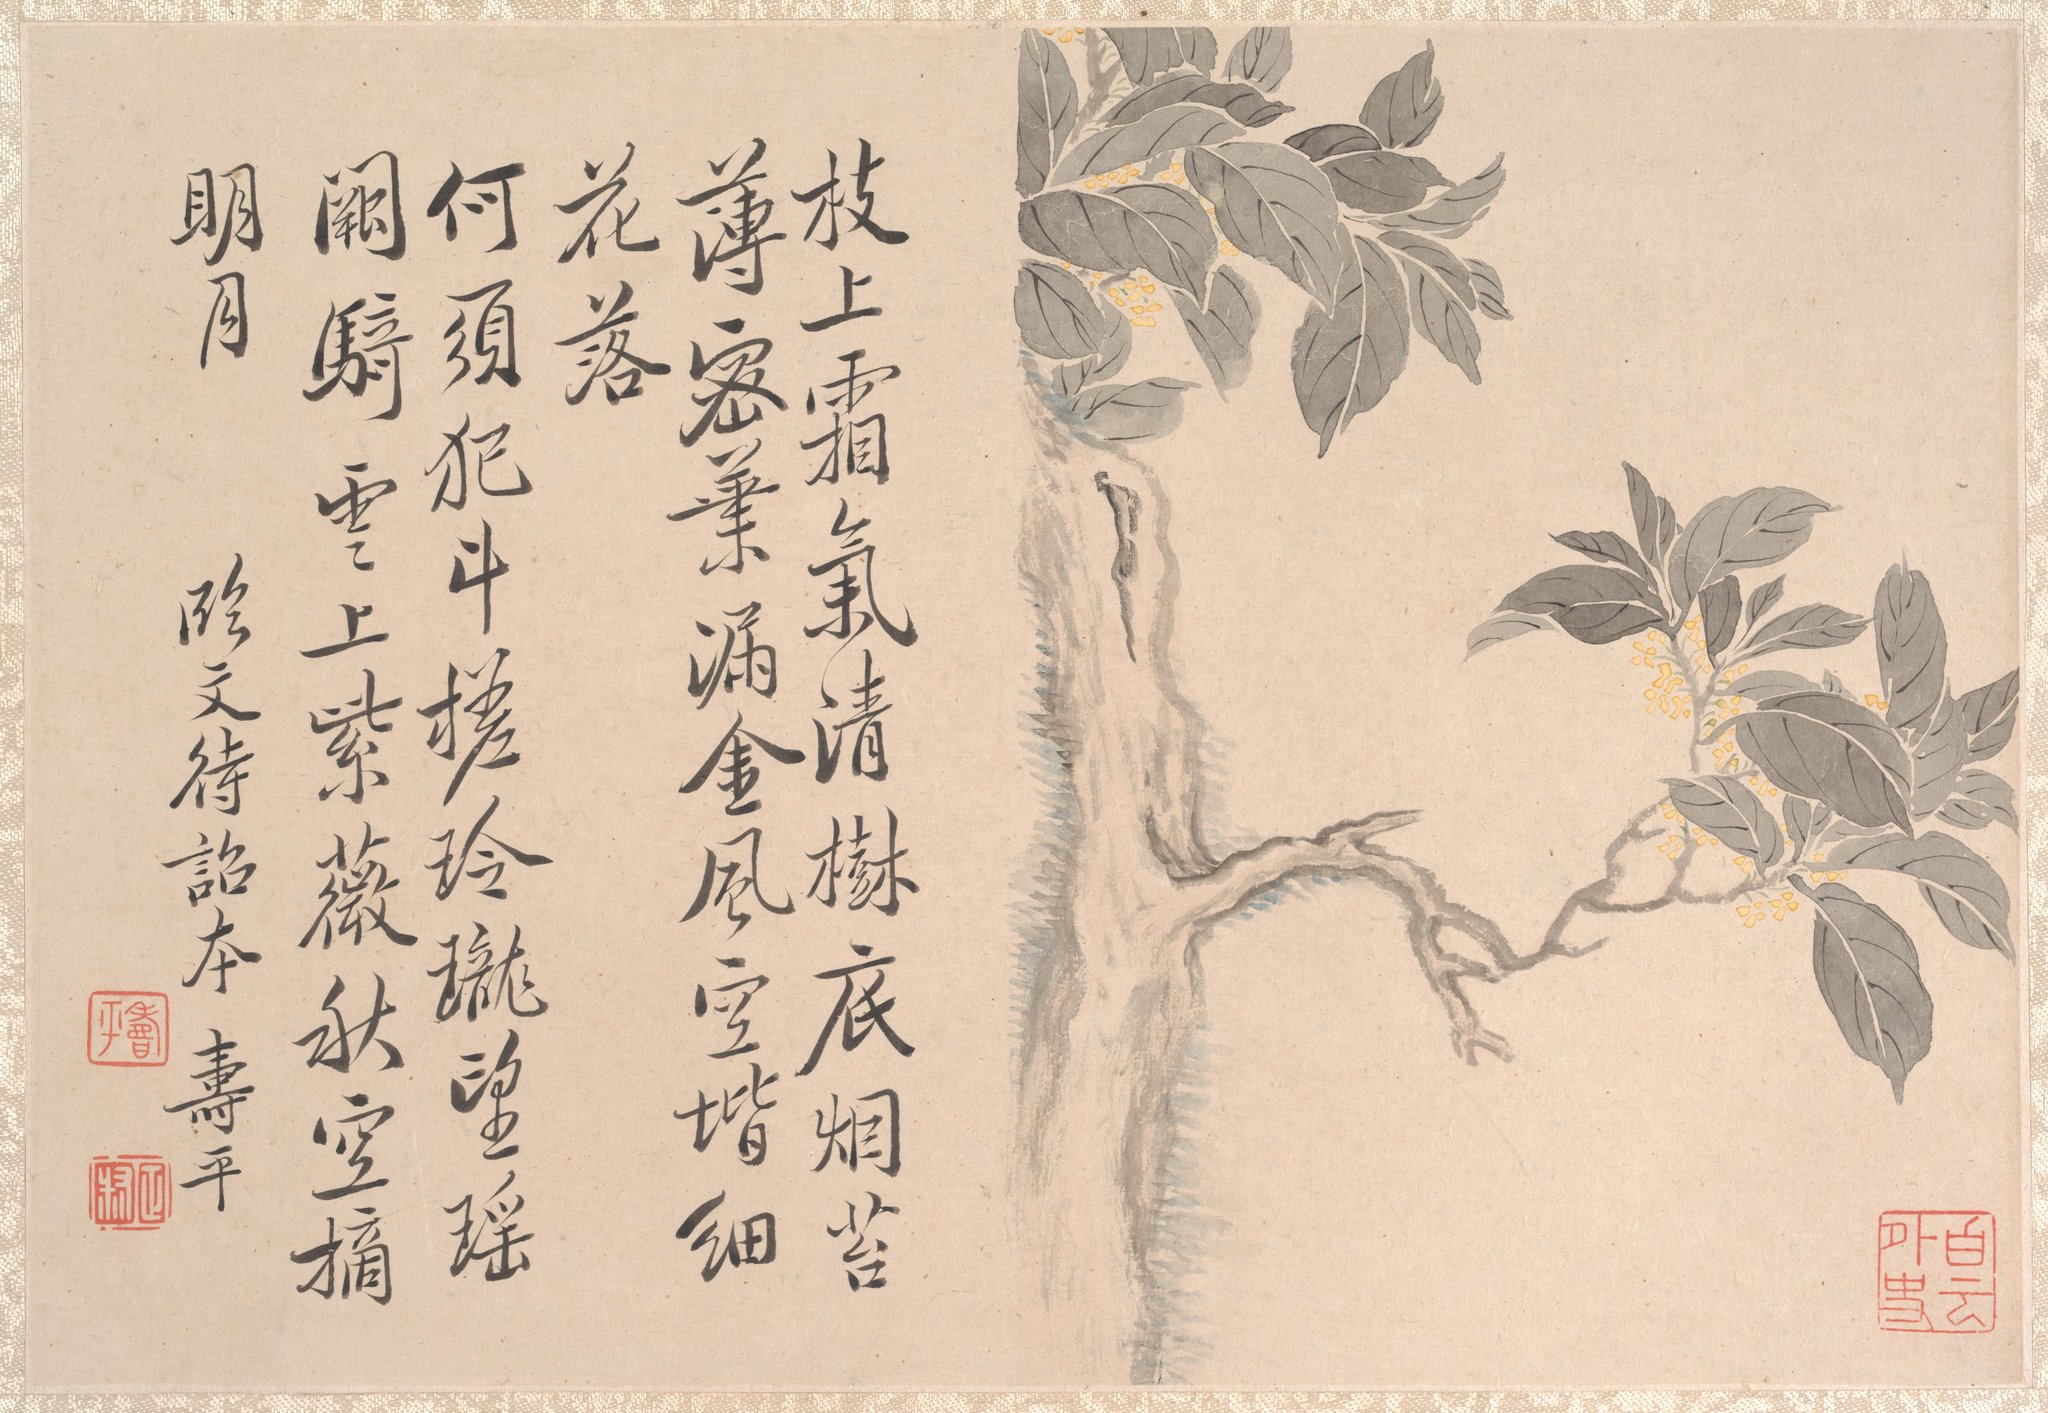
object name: album leaf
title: Cassia Tree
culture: chinese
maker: unidentified artist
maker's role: artist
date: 1644-1911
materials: ink, paper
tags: trees